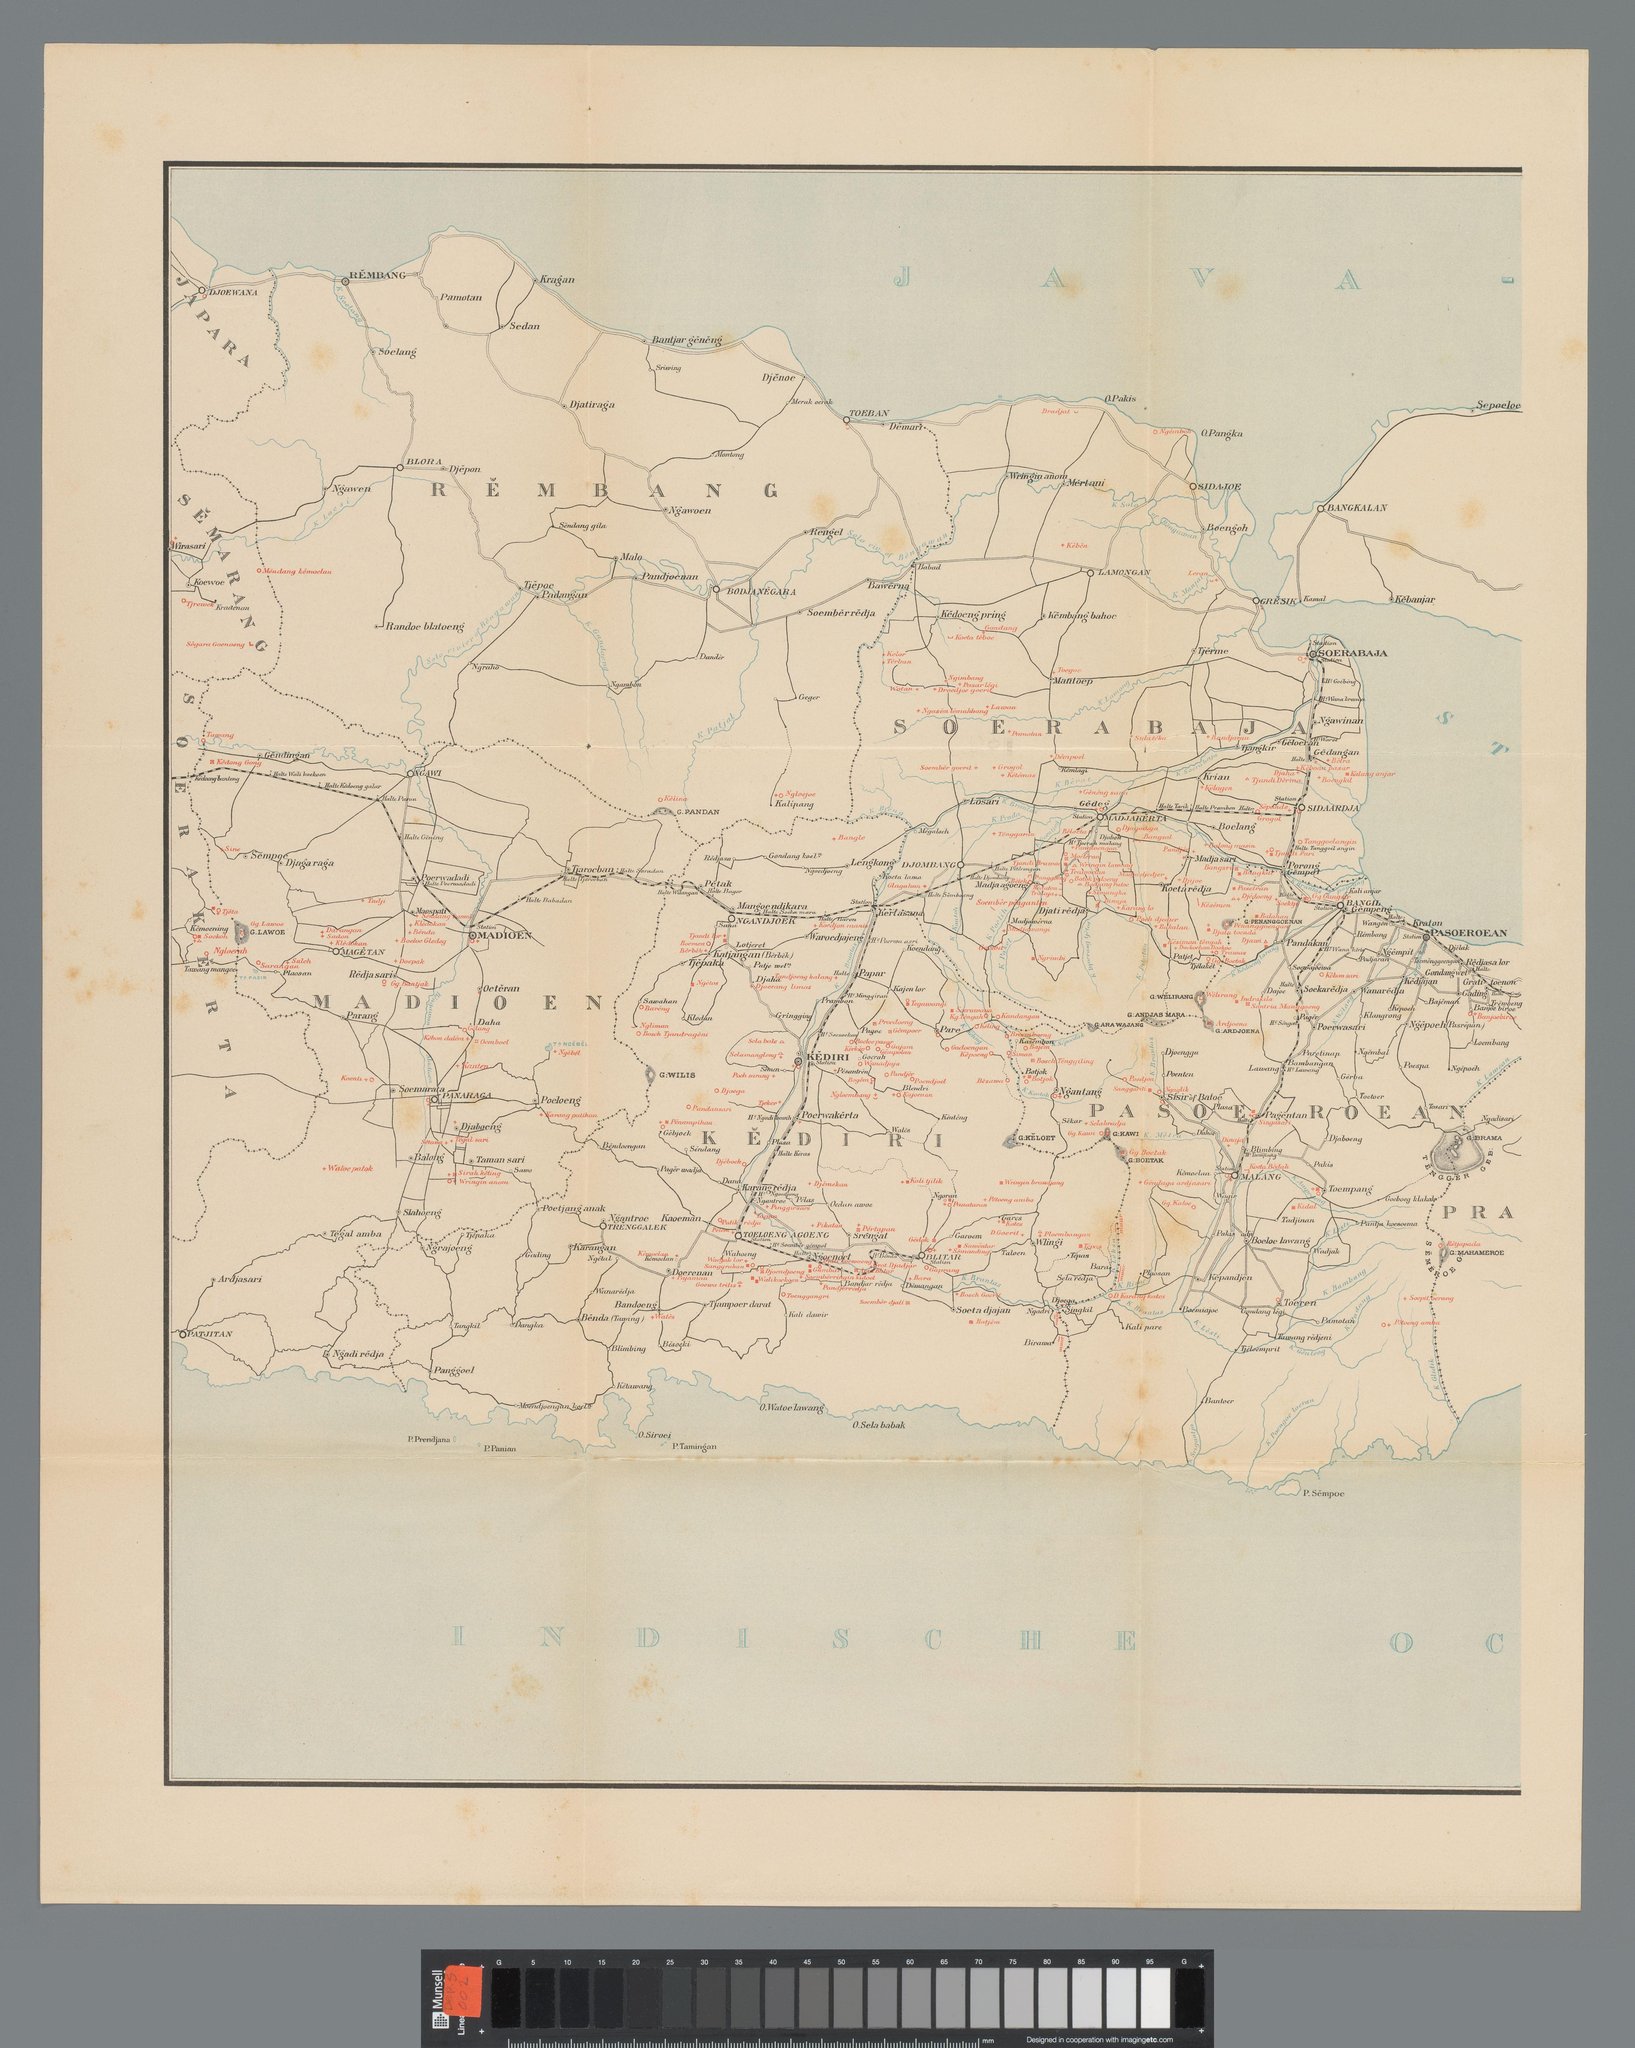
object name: map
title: Kaart van Oost-Java, linkerdeel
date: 1889-1891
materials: paper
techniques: lithograph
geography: the hague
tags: maps of separate countries or regions, java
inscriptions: collector's mark: ‘Bibliotheek Rijksmuseum Amsterdam’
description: Prent ook gebruikt in: Verhandelingen van het Bataafsch Genootschap (...). Den Haag: Martinus Nijhoff, dl. 46, 1891.